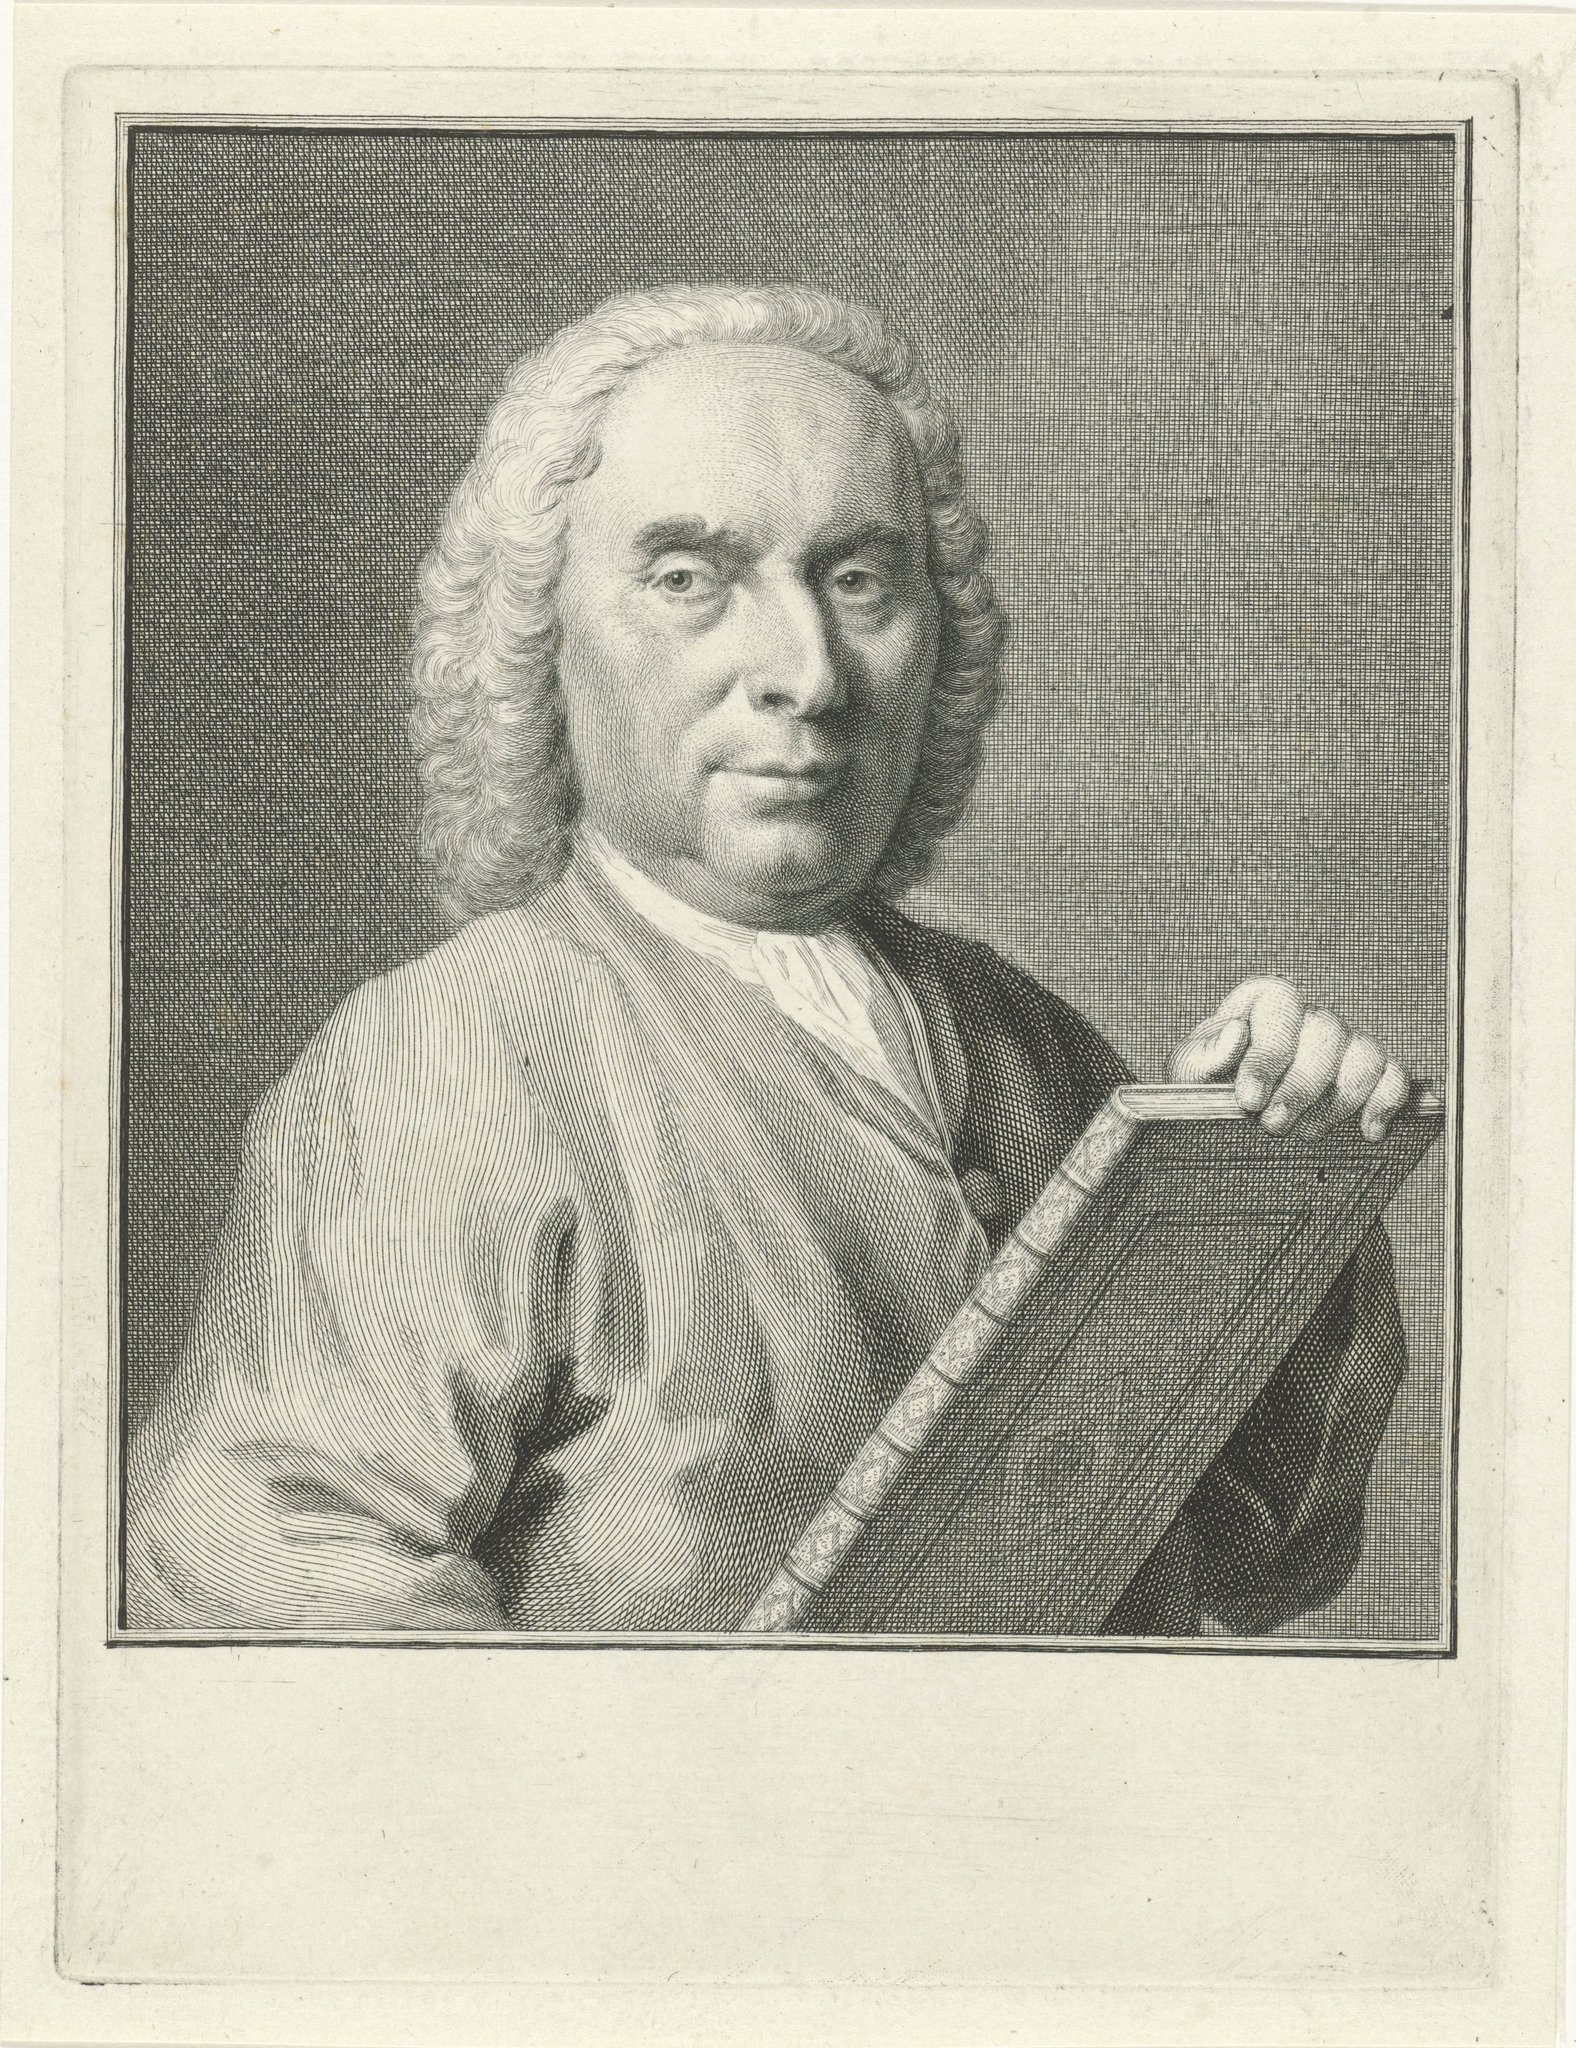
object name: print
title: Portret van Pieter Langendijk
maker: jacob houbraken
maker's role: draughtsman, print maker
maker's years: 1698-1780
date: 1749-1751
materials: paper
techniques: engraving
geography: amsterdam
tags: pieter langendijk (i)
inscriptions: collector's mark: Lugt 240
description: Portret naar rechts van Pieter Langendijk met in zijn hand een boek.